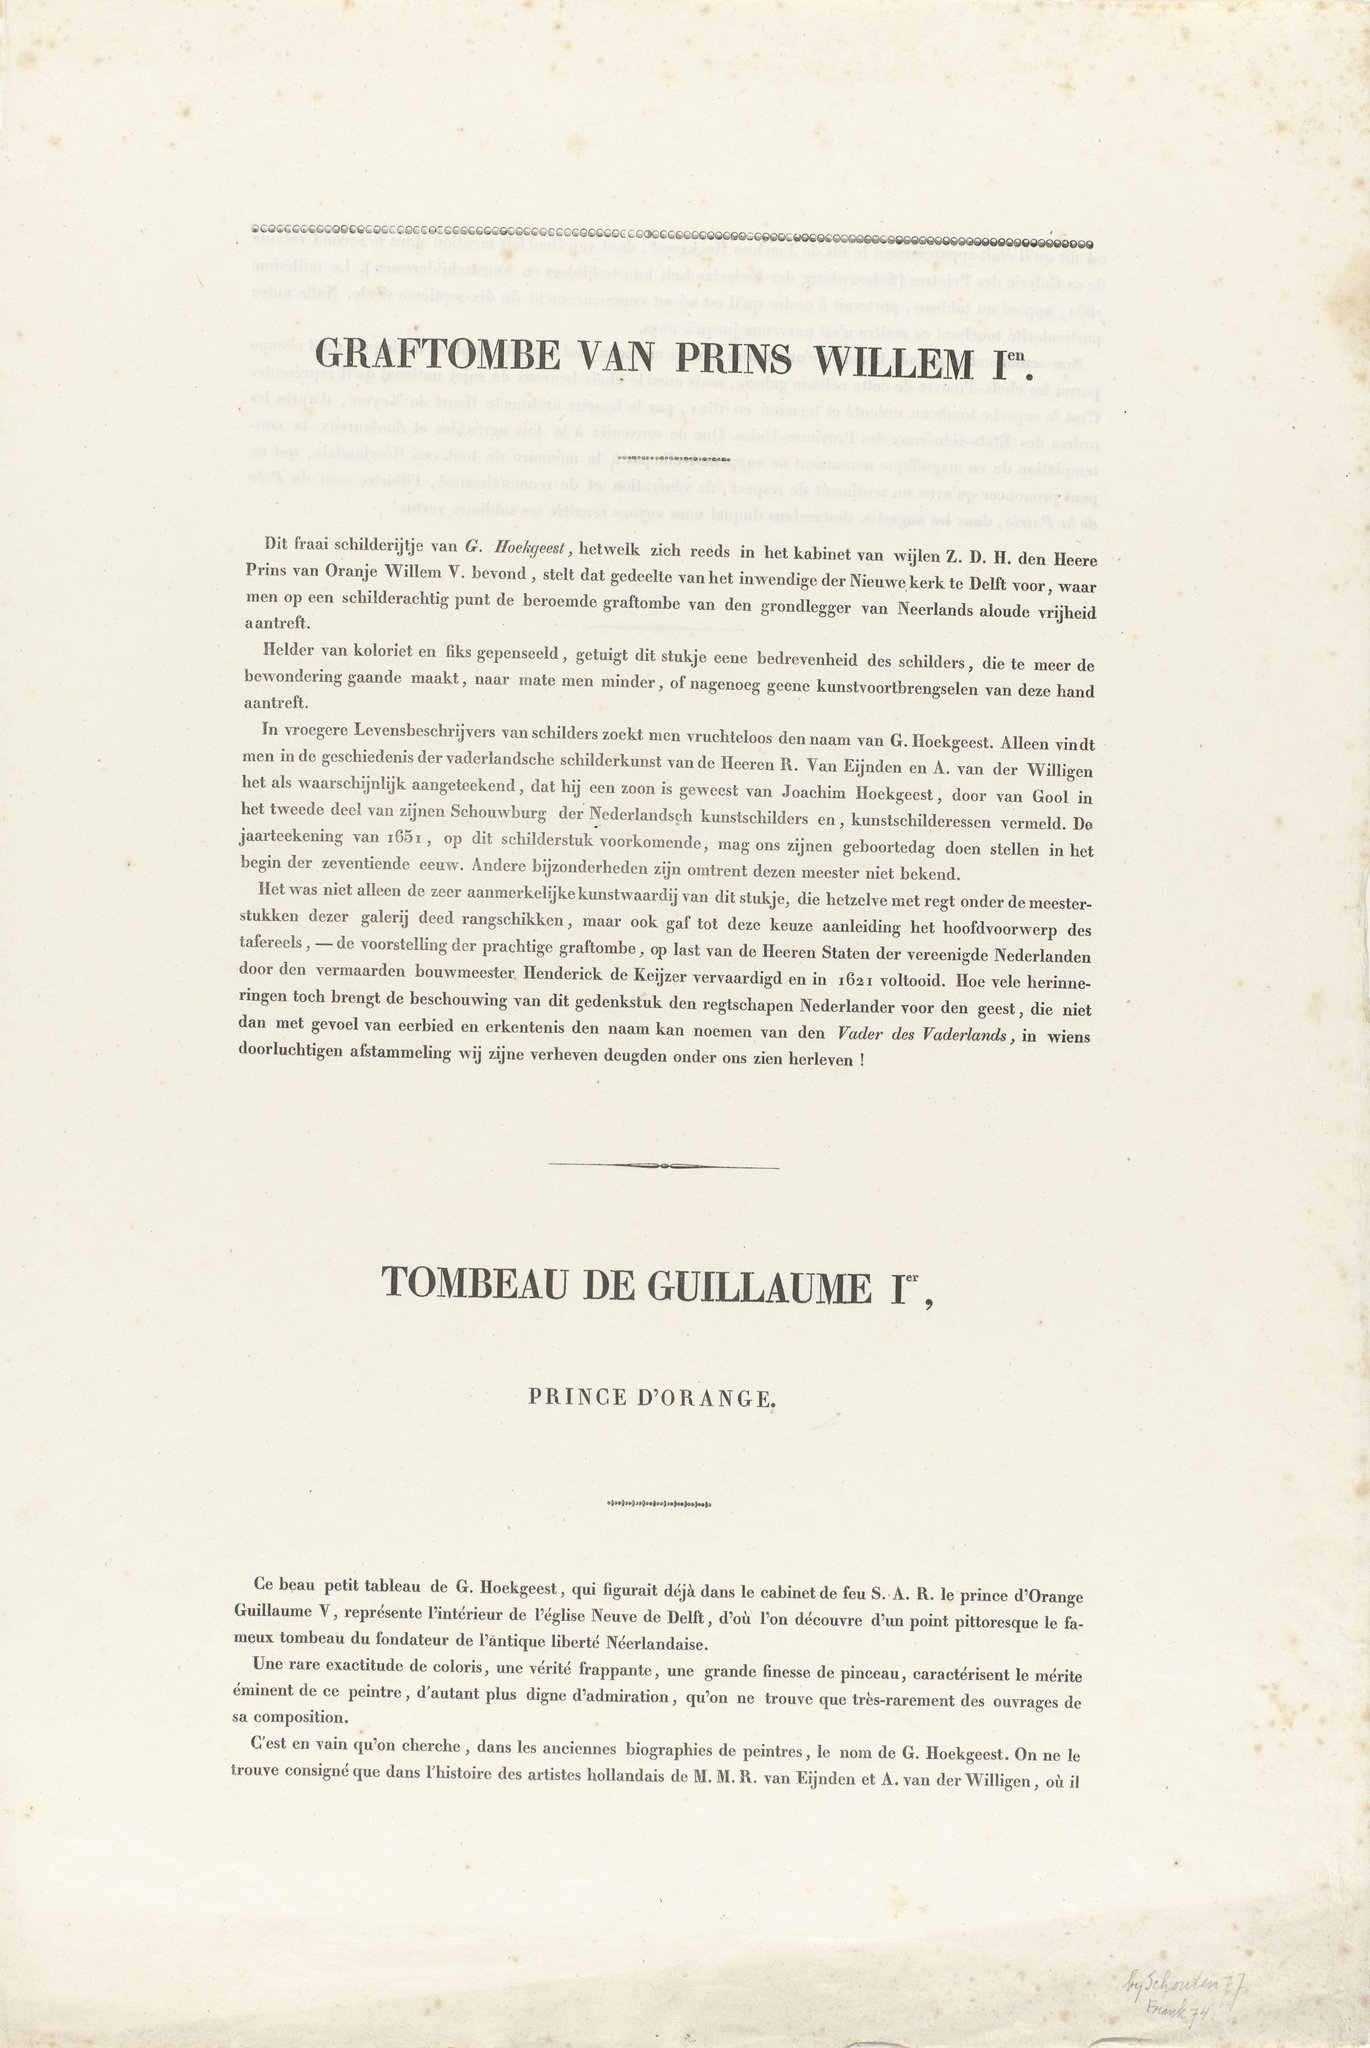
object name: text sheet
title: Tekst bij de graftombe van Willem I, prins van Oranje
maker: Anonymous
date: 1856-1879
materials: paper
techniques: letterpress printing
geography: netherlands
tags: delft, william i (prince of orange), historical persons, interior of church, grave-building, monumental tomb